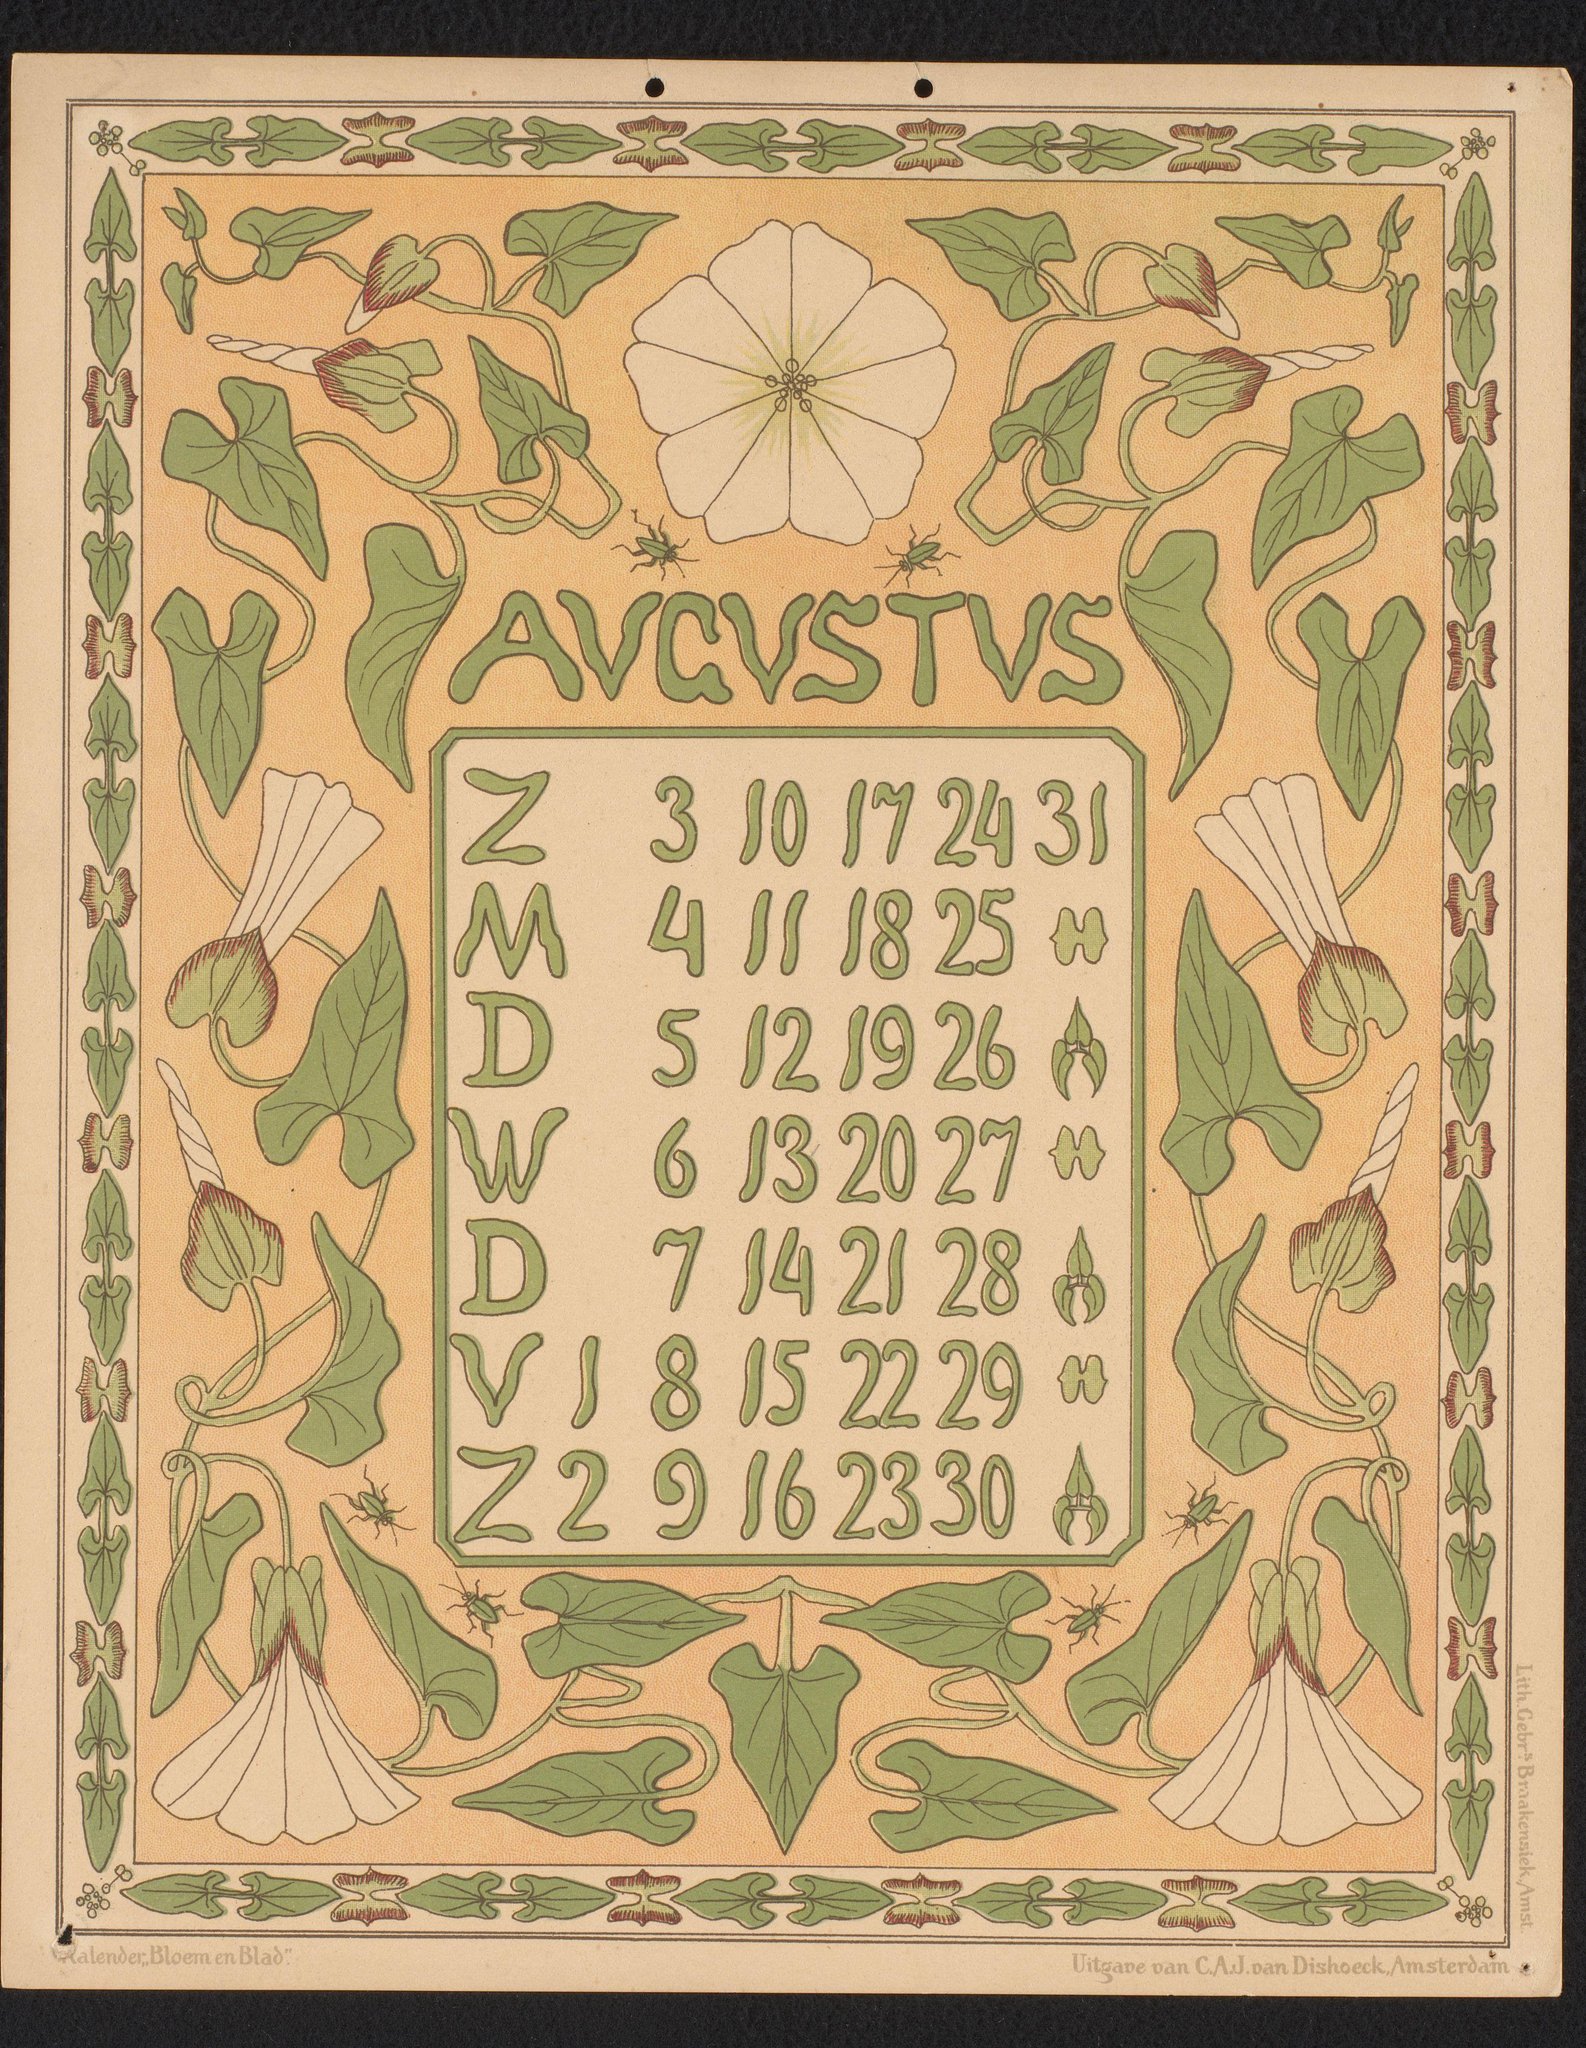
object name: print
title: Kalenderblad voor augustus 1902 met akkerwinde en kevers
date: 1901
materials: paper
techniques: lithograph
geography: amsterdam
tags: flowers, calendar, almanac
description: Decoratieve rand van akkerwinde en kevertjes rond de maandkalender voor augustus. Kalender 'Bloem en Blad'.